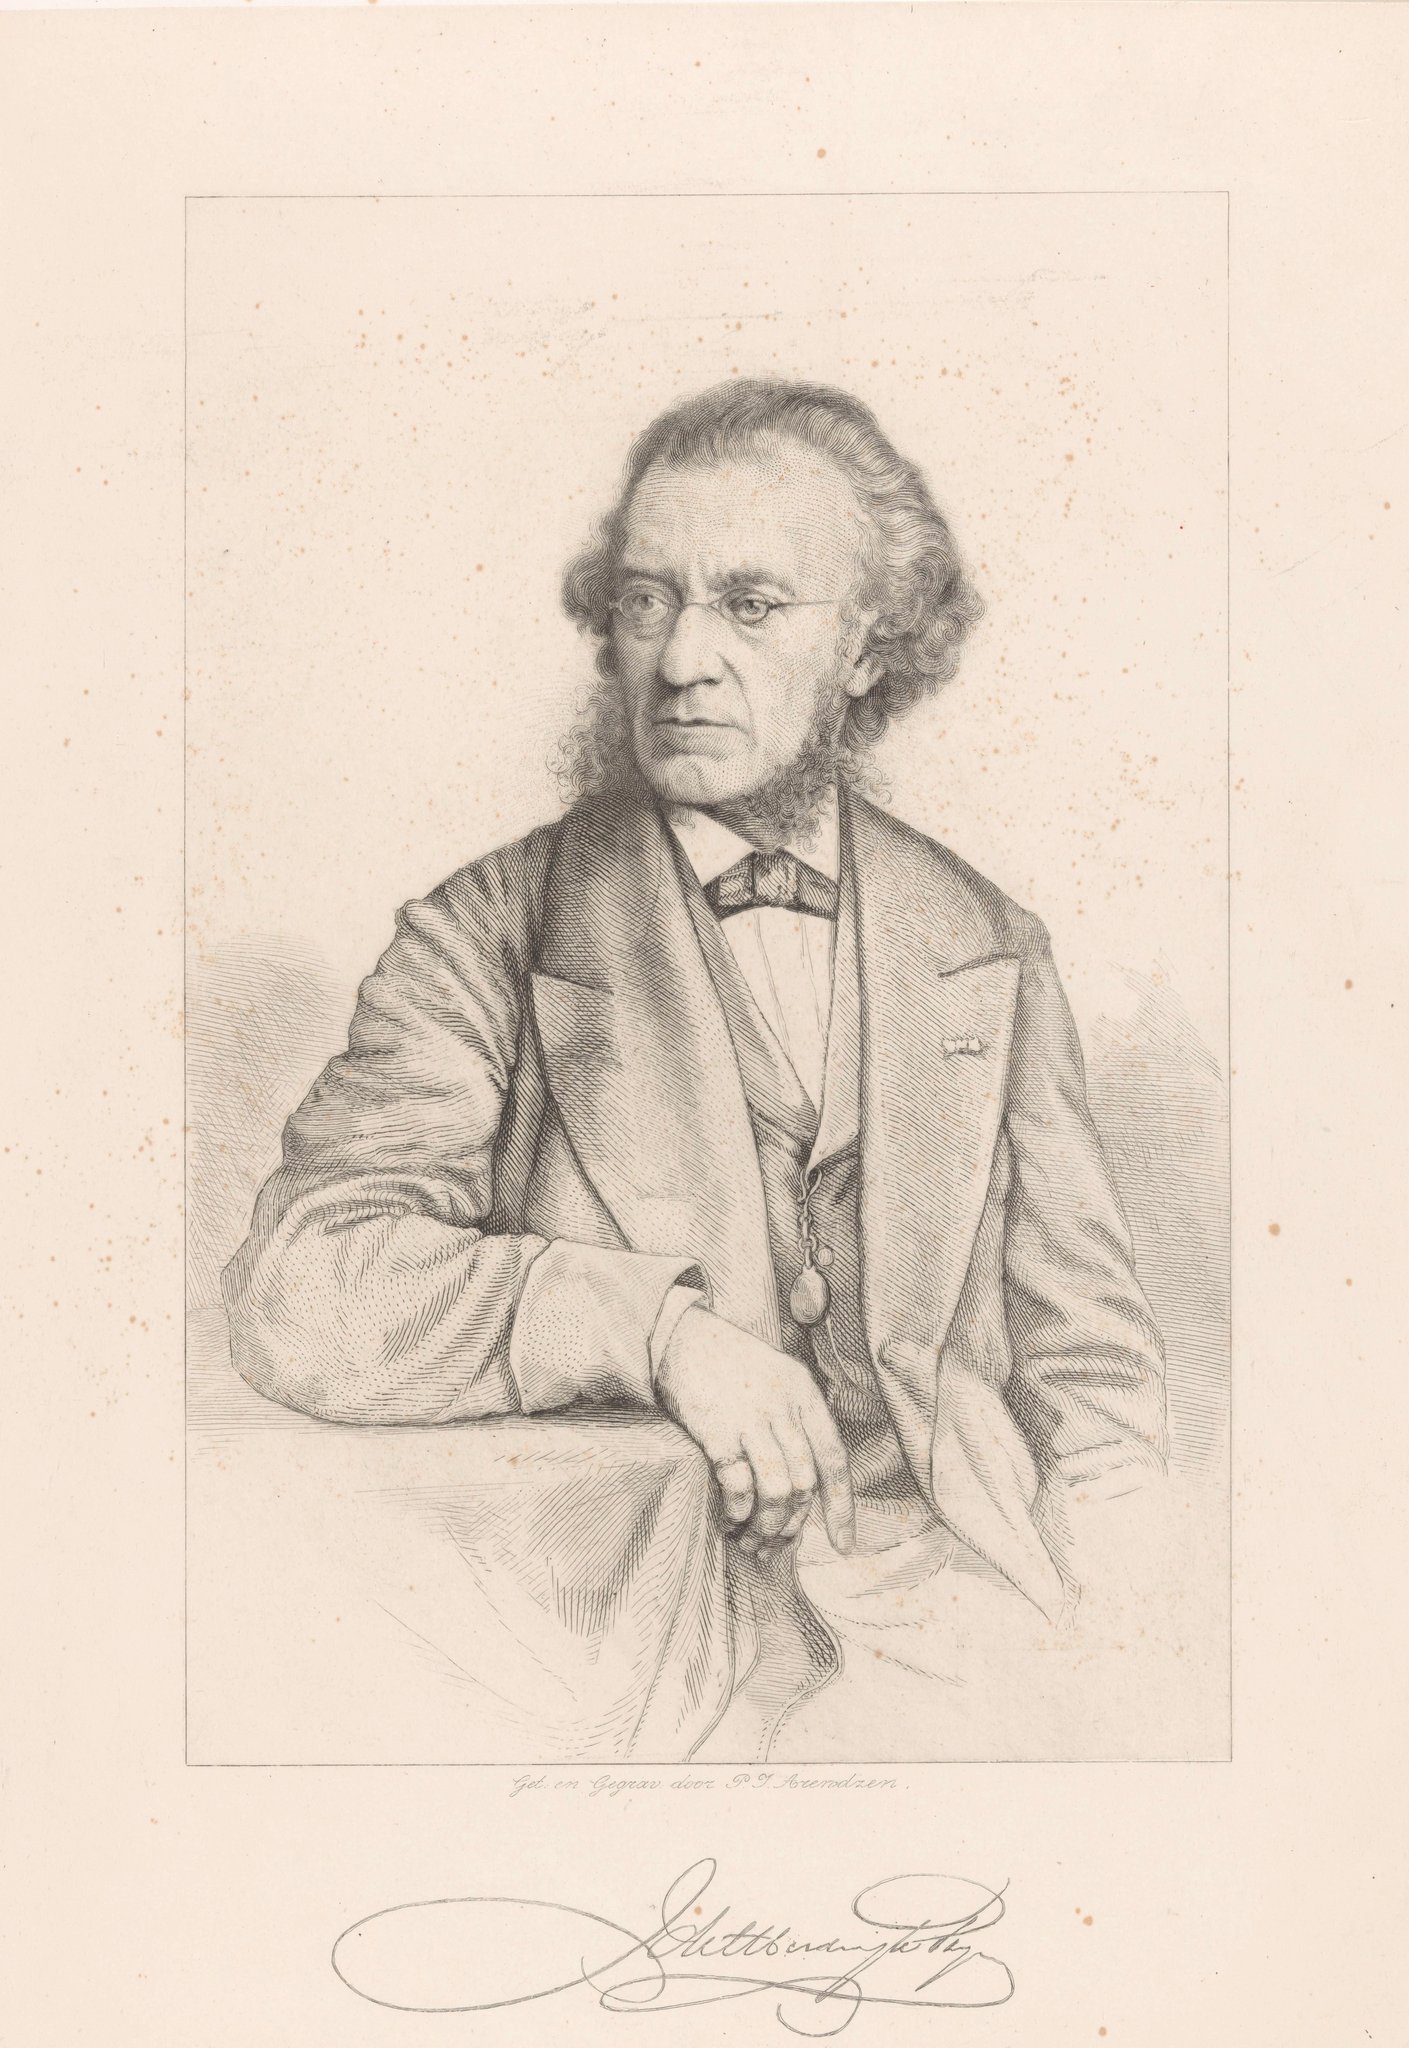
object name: print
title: Portret van Josephus Albertus Alberdingk Thijm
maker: petrus johannes arendzen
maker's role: draughtsman, print maker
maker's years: 1846-1932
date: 1856-1932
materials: paper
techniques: engraving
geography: amsterdam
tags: draughtsman, josephus albertus alberdingk thijm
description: Portret van Josephus Albertus Alberdingk Thijm in een rechthoekige omlijsting. Hij zit in een stoel aan een tafel. In de ondermarge zijn handtekening.